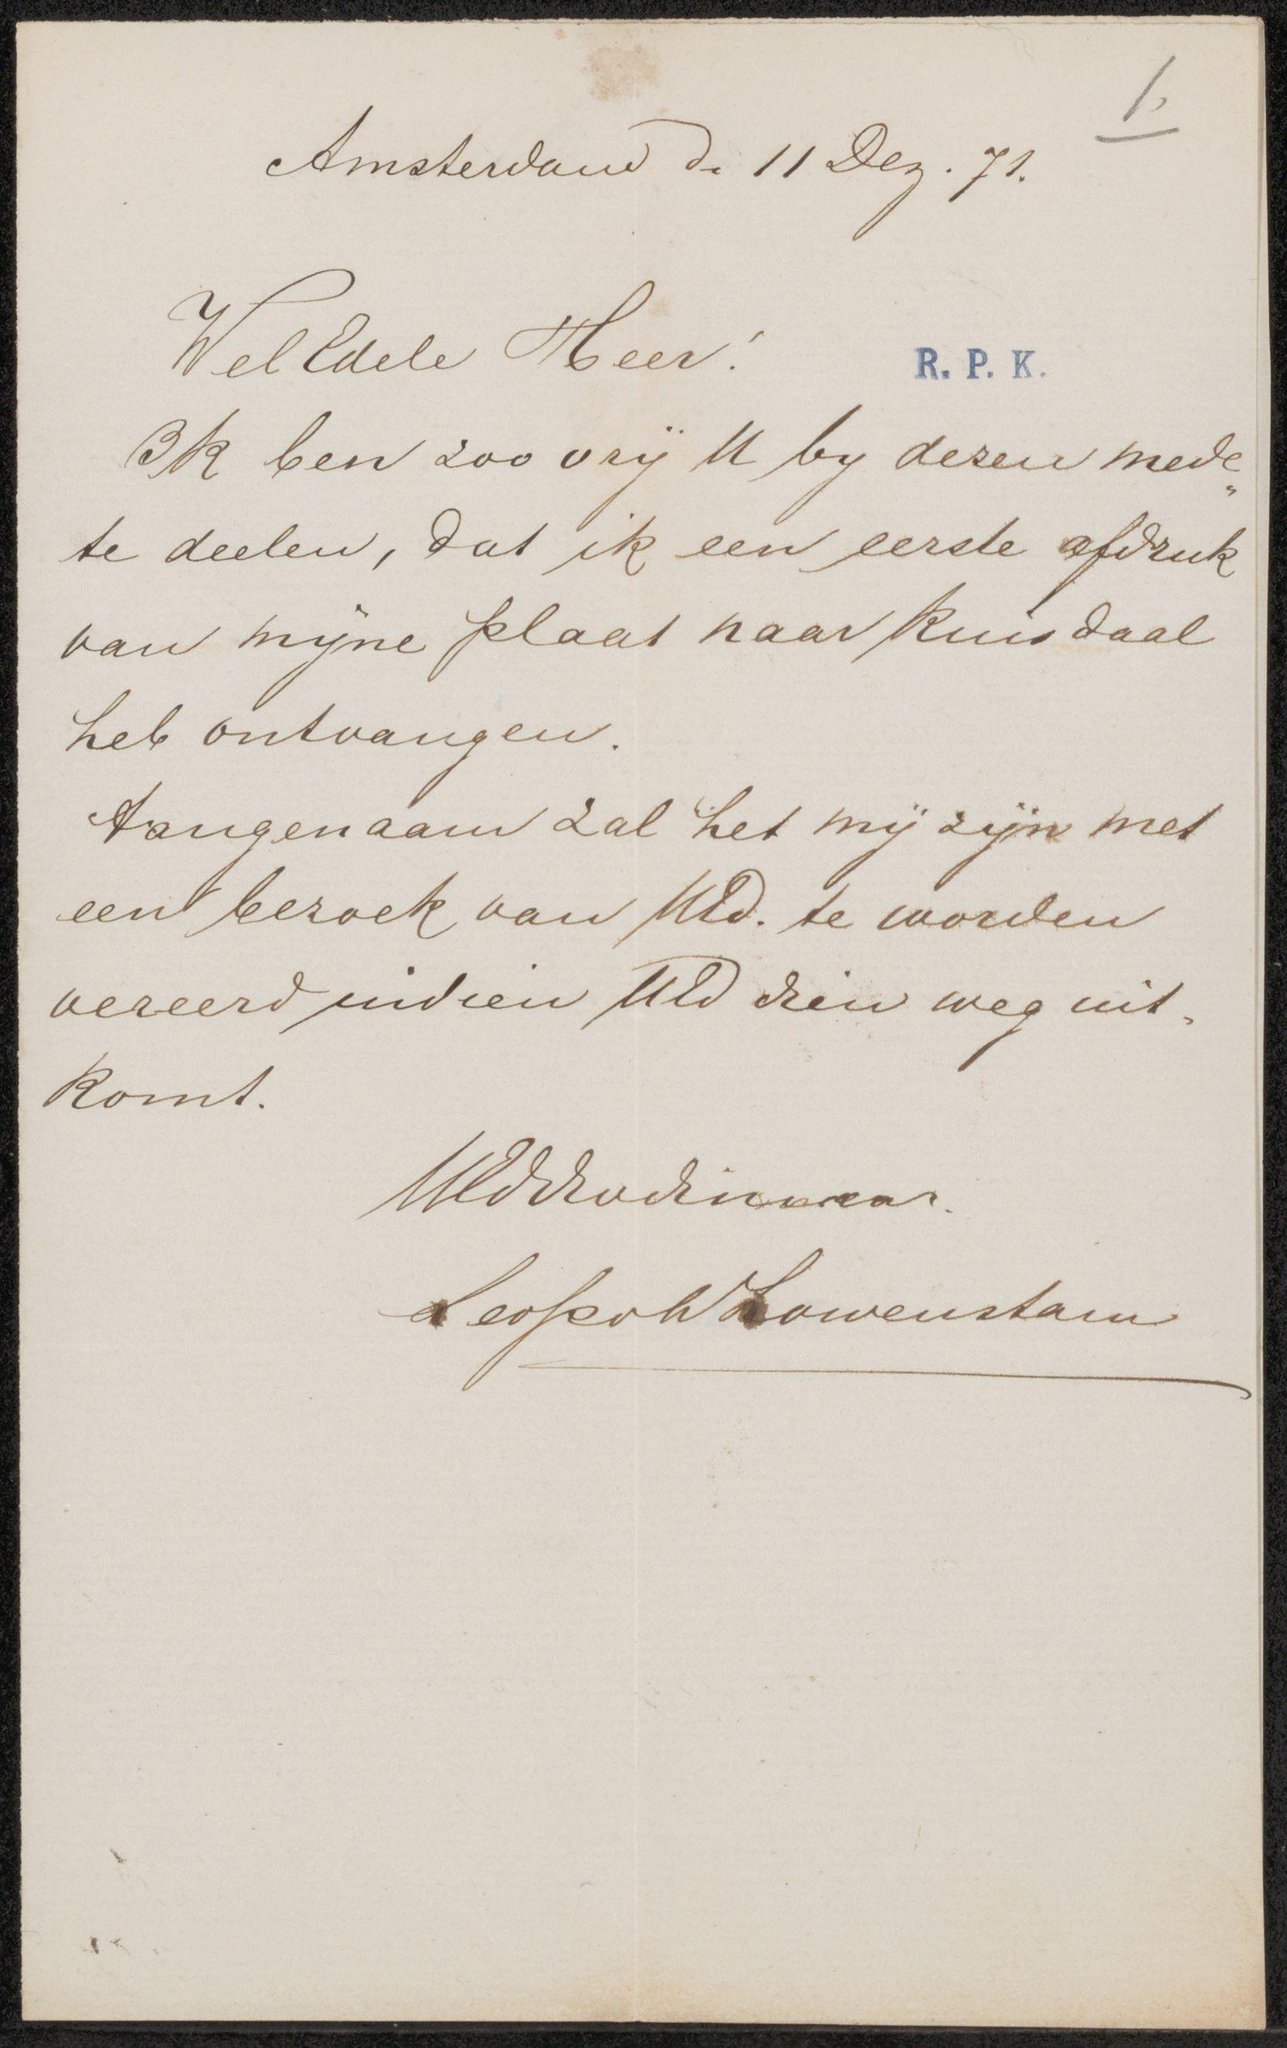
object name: letter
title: Brief aan Frans Buffa en Zonen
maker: leopold löwenstam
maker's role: print maker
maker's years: 1842-1898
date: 1871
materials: ink, paper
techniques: pen, writing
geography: amsterdam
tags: publisher, haarlem, painter, print maker, draughtsman, jacob isaacksz van ruisdael, the graphic arts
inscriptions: collector's mark: Lugt 2233